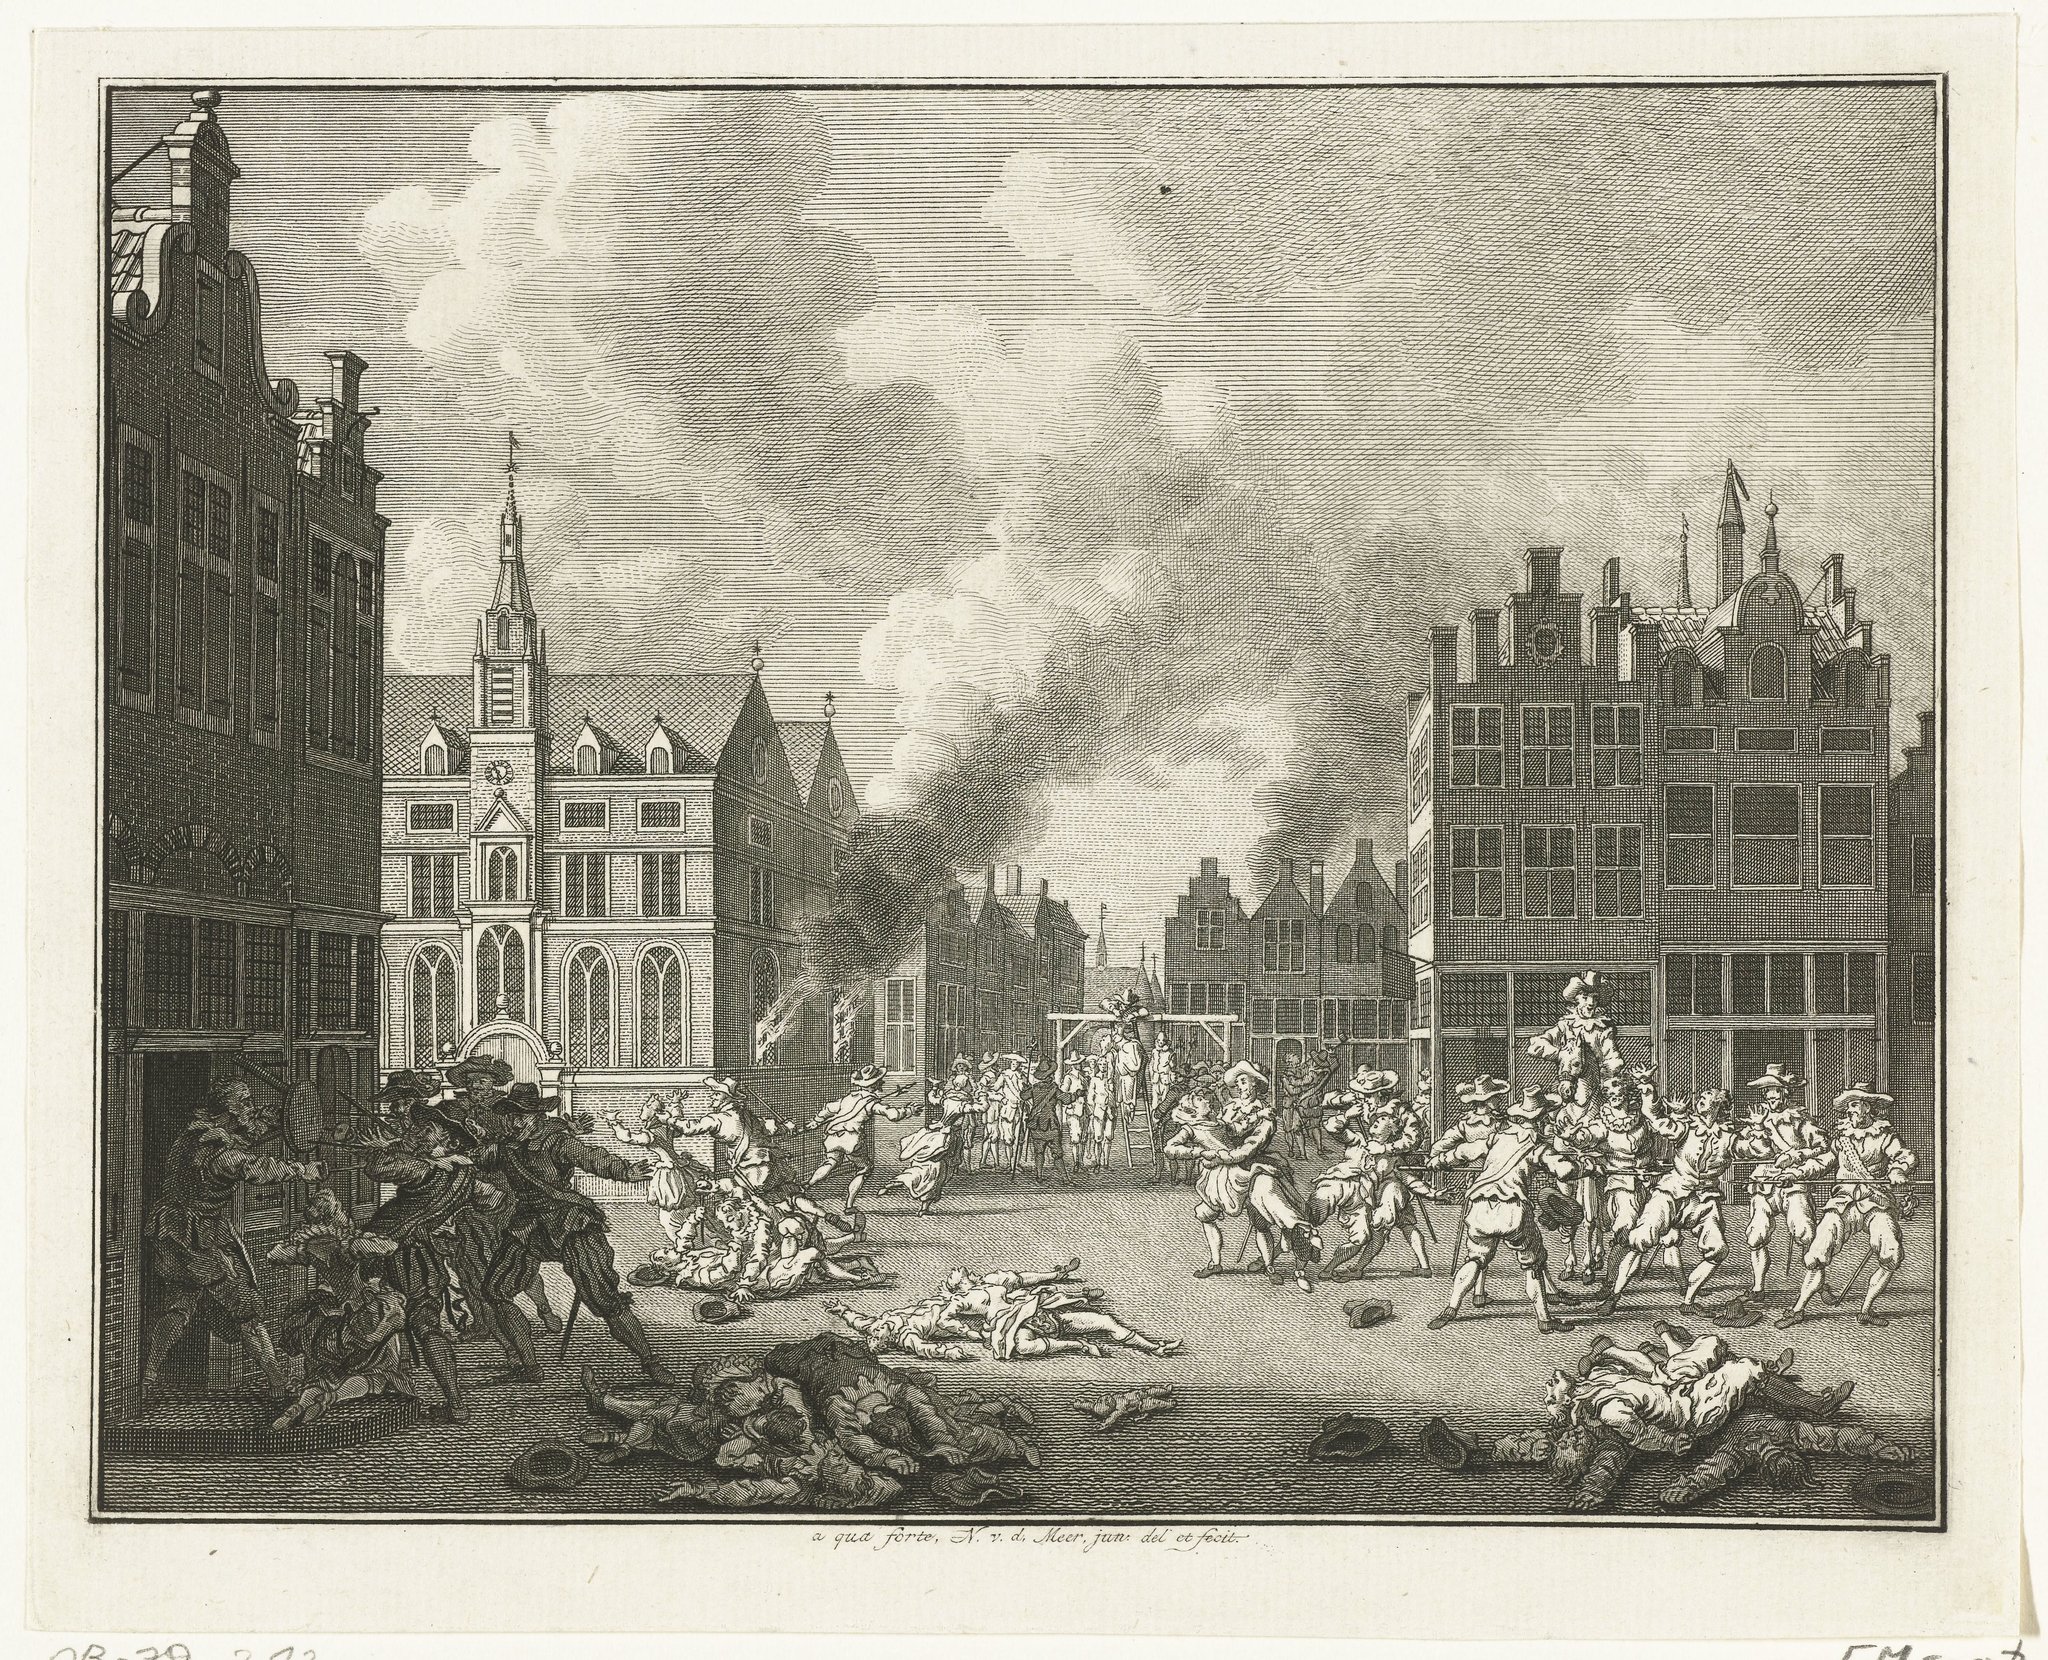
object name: history print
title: Het Bloedbad van Naarden, 1572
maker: noach van der meer (ii)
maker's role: draughtsman, print maker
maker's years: 1741-1822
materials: paper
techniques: etching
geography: netherlands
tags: setting on fire (of conquered city), destruction of conquered city, massacre ~ war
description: Op 1 december 1572 werd een groot deel van de bevolking van Naarden door de Spanjaarden vermoord, nadat de stad zich aan de Spaanse troepen had overgegeven. Op het stadsplein worden burgers neergeschoten en opgehangen. Op straat liggen lijken en de huizen staan in brand.